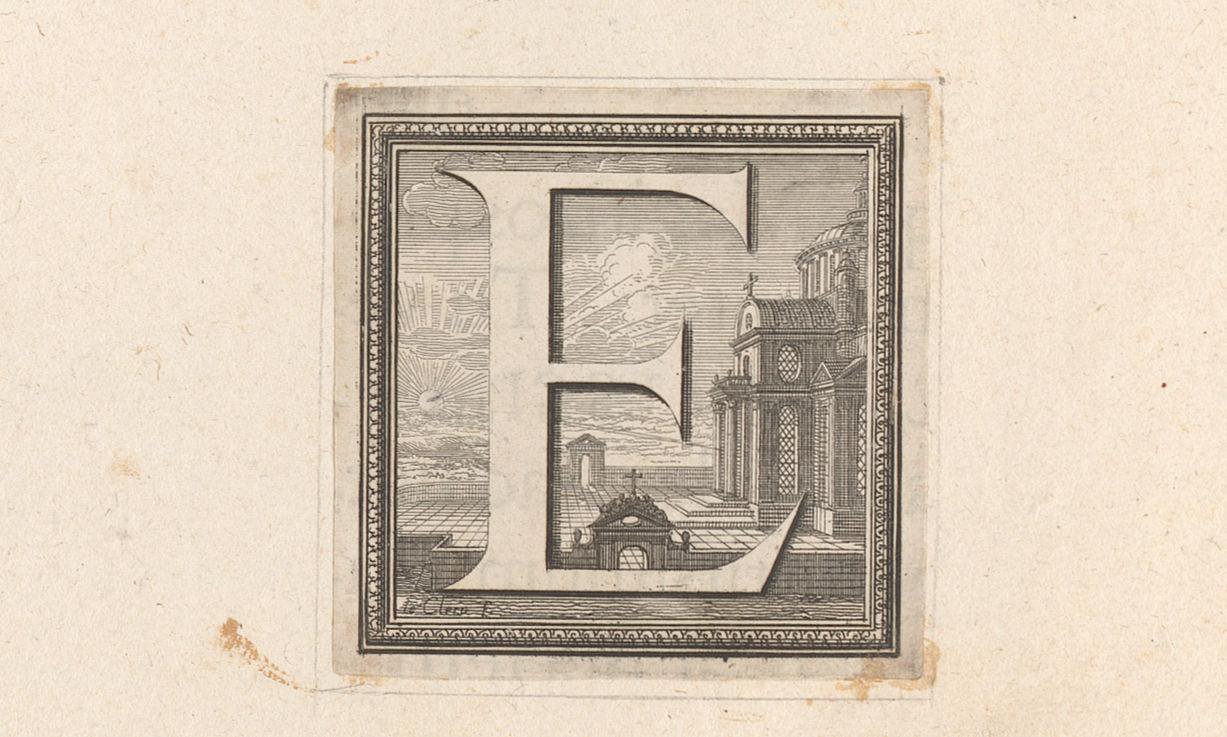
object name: album leaf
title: Initiaal 'E' met een gezicht op een kerk en de binnenplaats van een kerk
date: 1676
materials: paper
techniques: etching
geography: paris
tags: initial, church (exterior)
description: Prent uit: Optat de Milève, Saint. Sancti Optati milevitani episcopi opera (...). Parijs: Jean Du Puis, 1676.